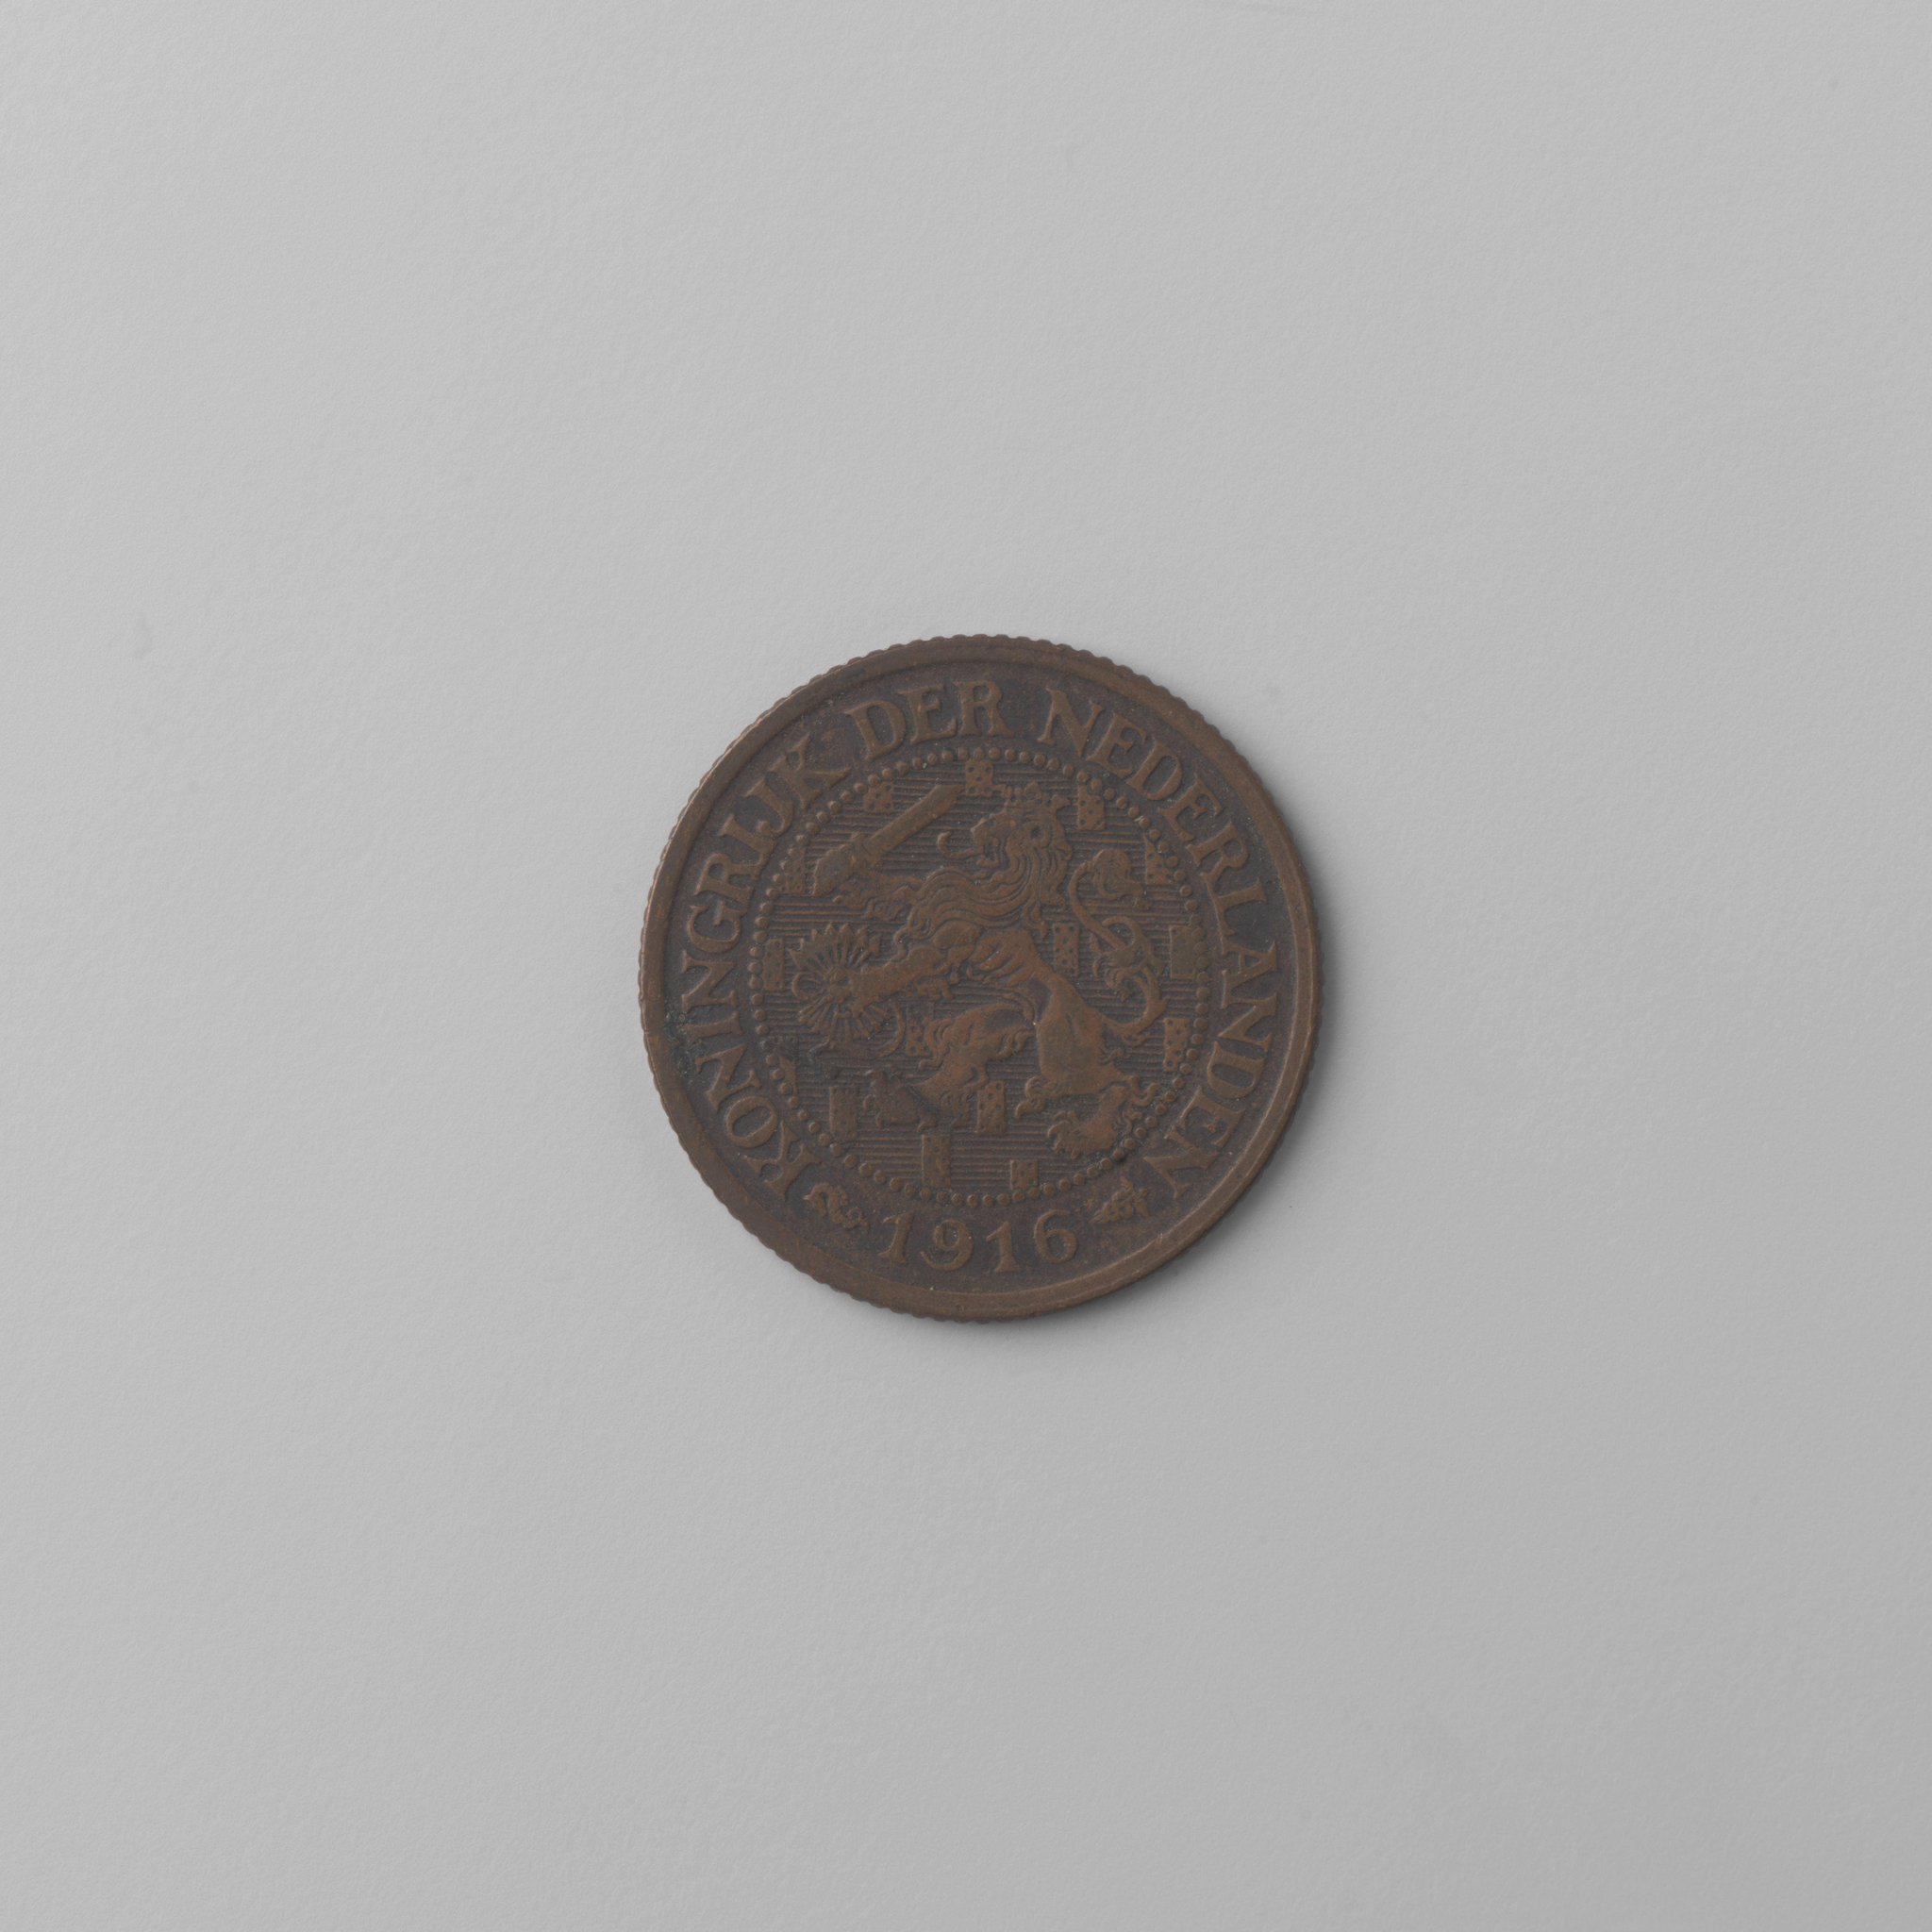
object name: coin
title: Nederlandse cent,1916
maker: wilhelmina of the netherlands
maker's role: print maker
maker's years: 1880-1962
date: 1916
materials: bronze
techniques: striking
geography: utrecht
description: Bronzen munt. Voorzijde: in een veld rijkswapen. Jaartal onderaan in omschrift. Keerzijde: binnen twee samengebonden oranjetakken waarde-aanduiding 1 cent. Kartelrand.